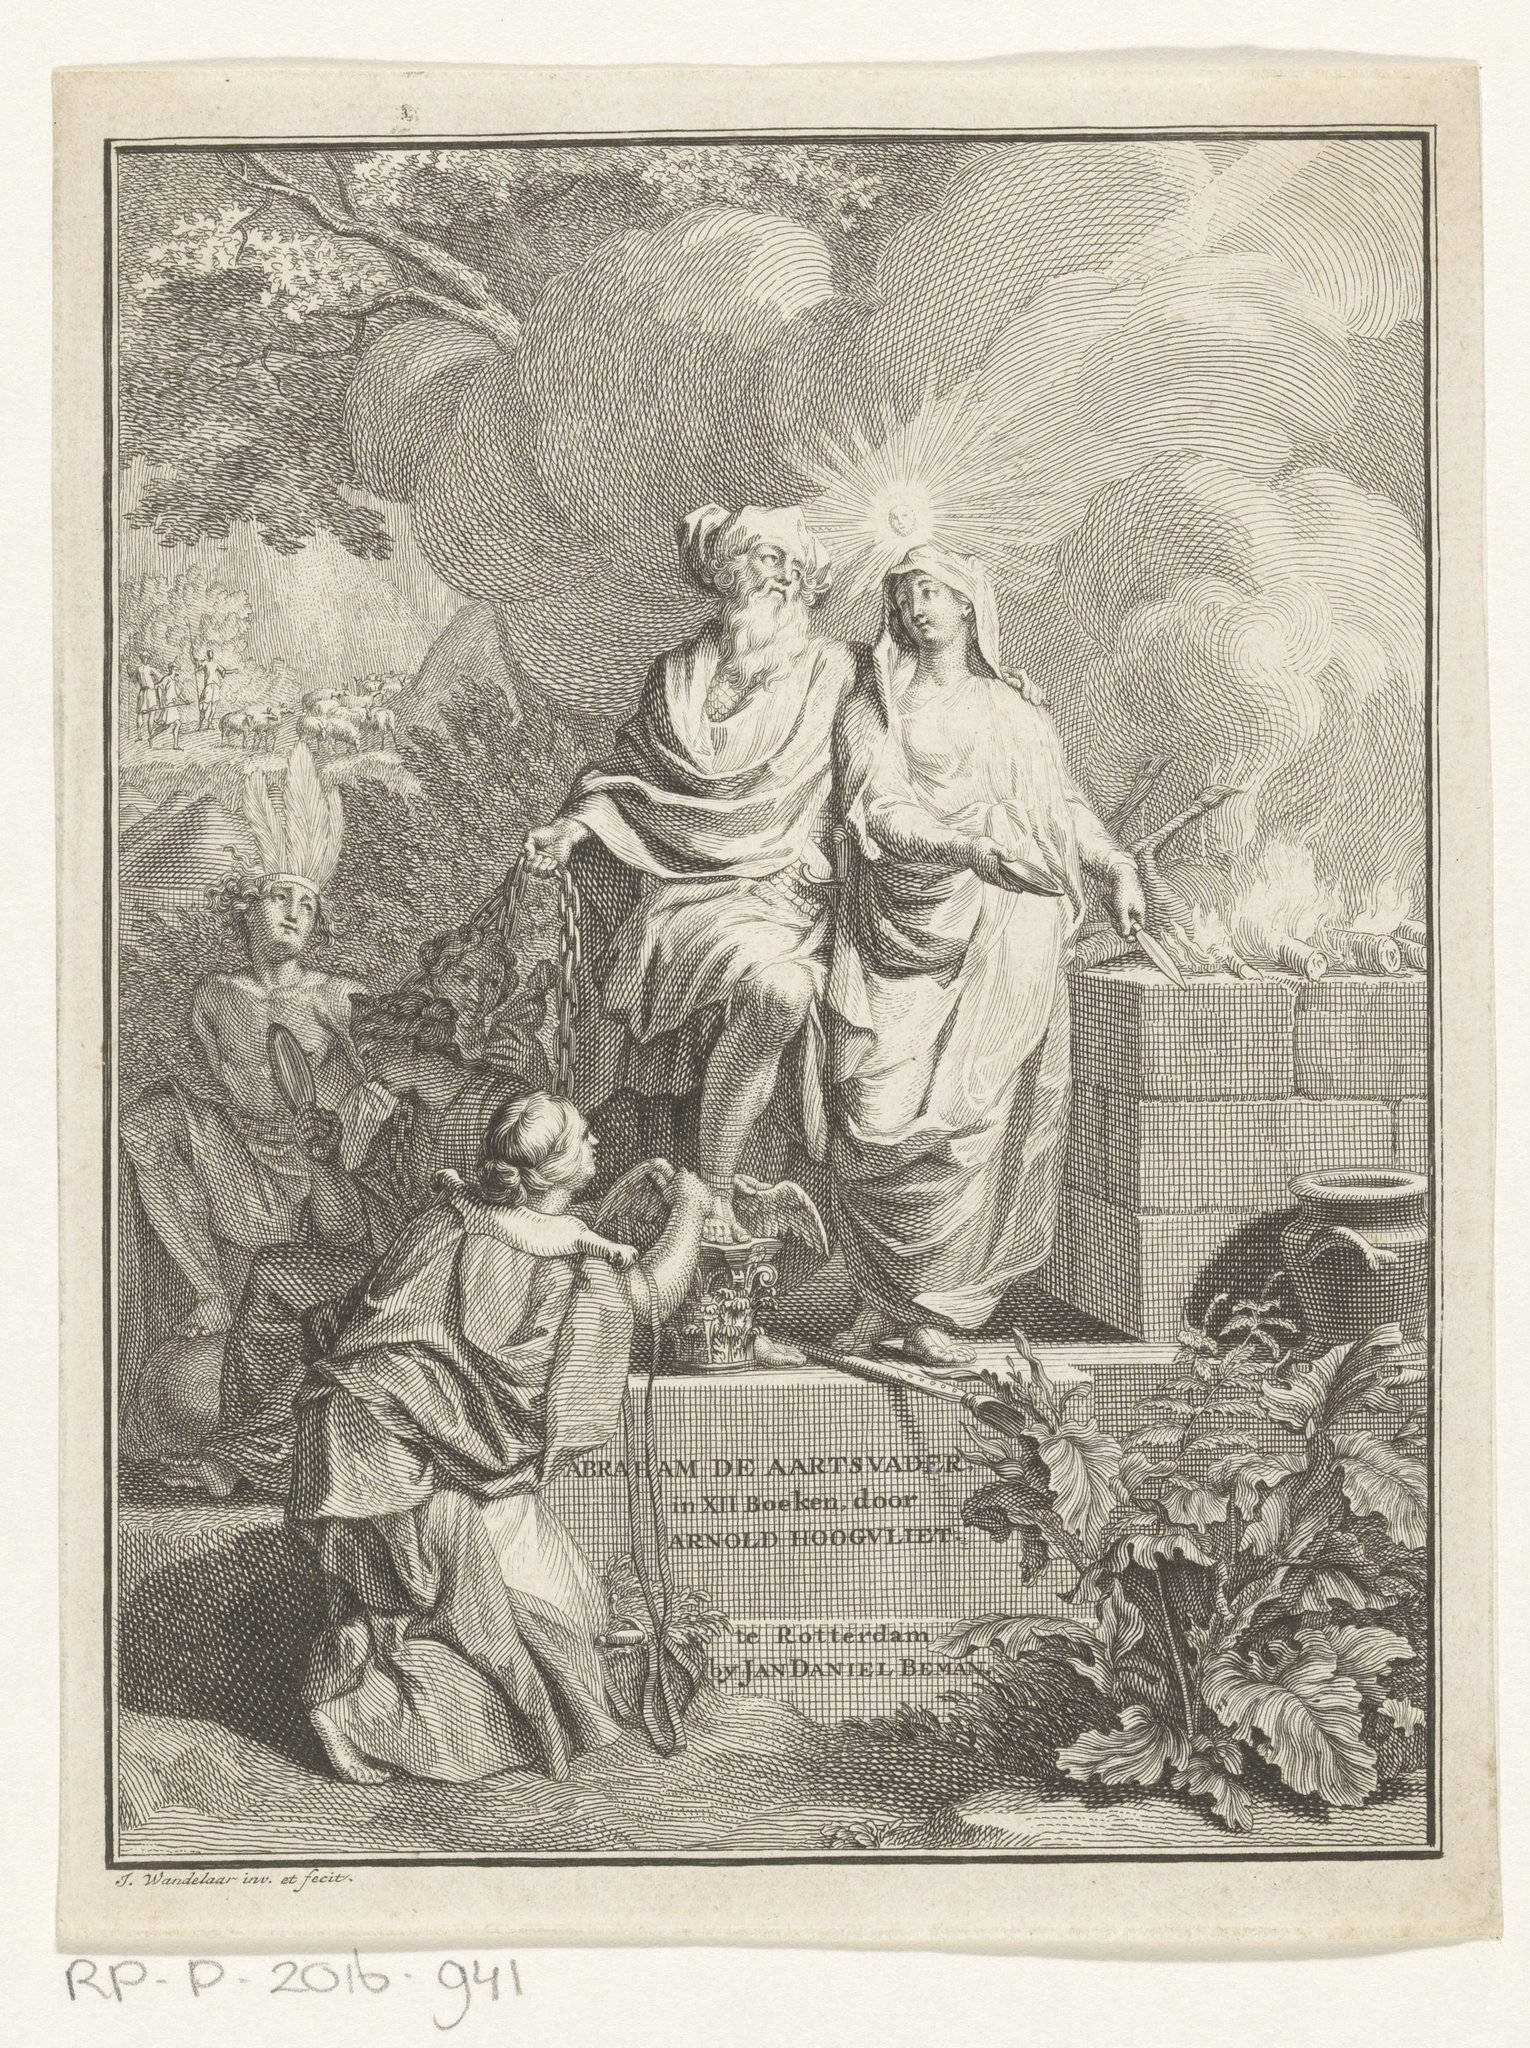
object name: print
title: Titelpagina voor: Arnold Hoogvliet, Abraham de aartsvader, in XII Boeken, 1728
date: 1728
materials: paper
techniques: engraving, etching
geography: rotterdam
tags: temperance, 'temperantia'; 'temperanza' (ripa) ~ one of the four cardinal virtues, paganism personified, truth; 'verità' (ripa), story of abraham, frivolity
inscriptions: collector's mark: Lugt 2228, collector's mark: Lugt 2760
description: Waarheid, een stralende zon boven haar hoofd, offert een lam op een altaar. In haar handen houdt ze een offerschaal en een mes. Naast haar de aartsvader Abraham, die de geketende IJdelheid, Afgoderij en een man met verentooi vasthoudt. Aan zijn voeten knielt Matigheid, met een paardentoom aan haar arm. Ze grijpt naar zijn gevleugelde voet. Links op de achtergrond drie herders met hun kudde schapen.